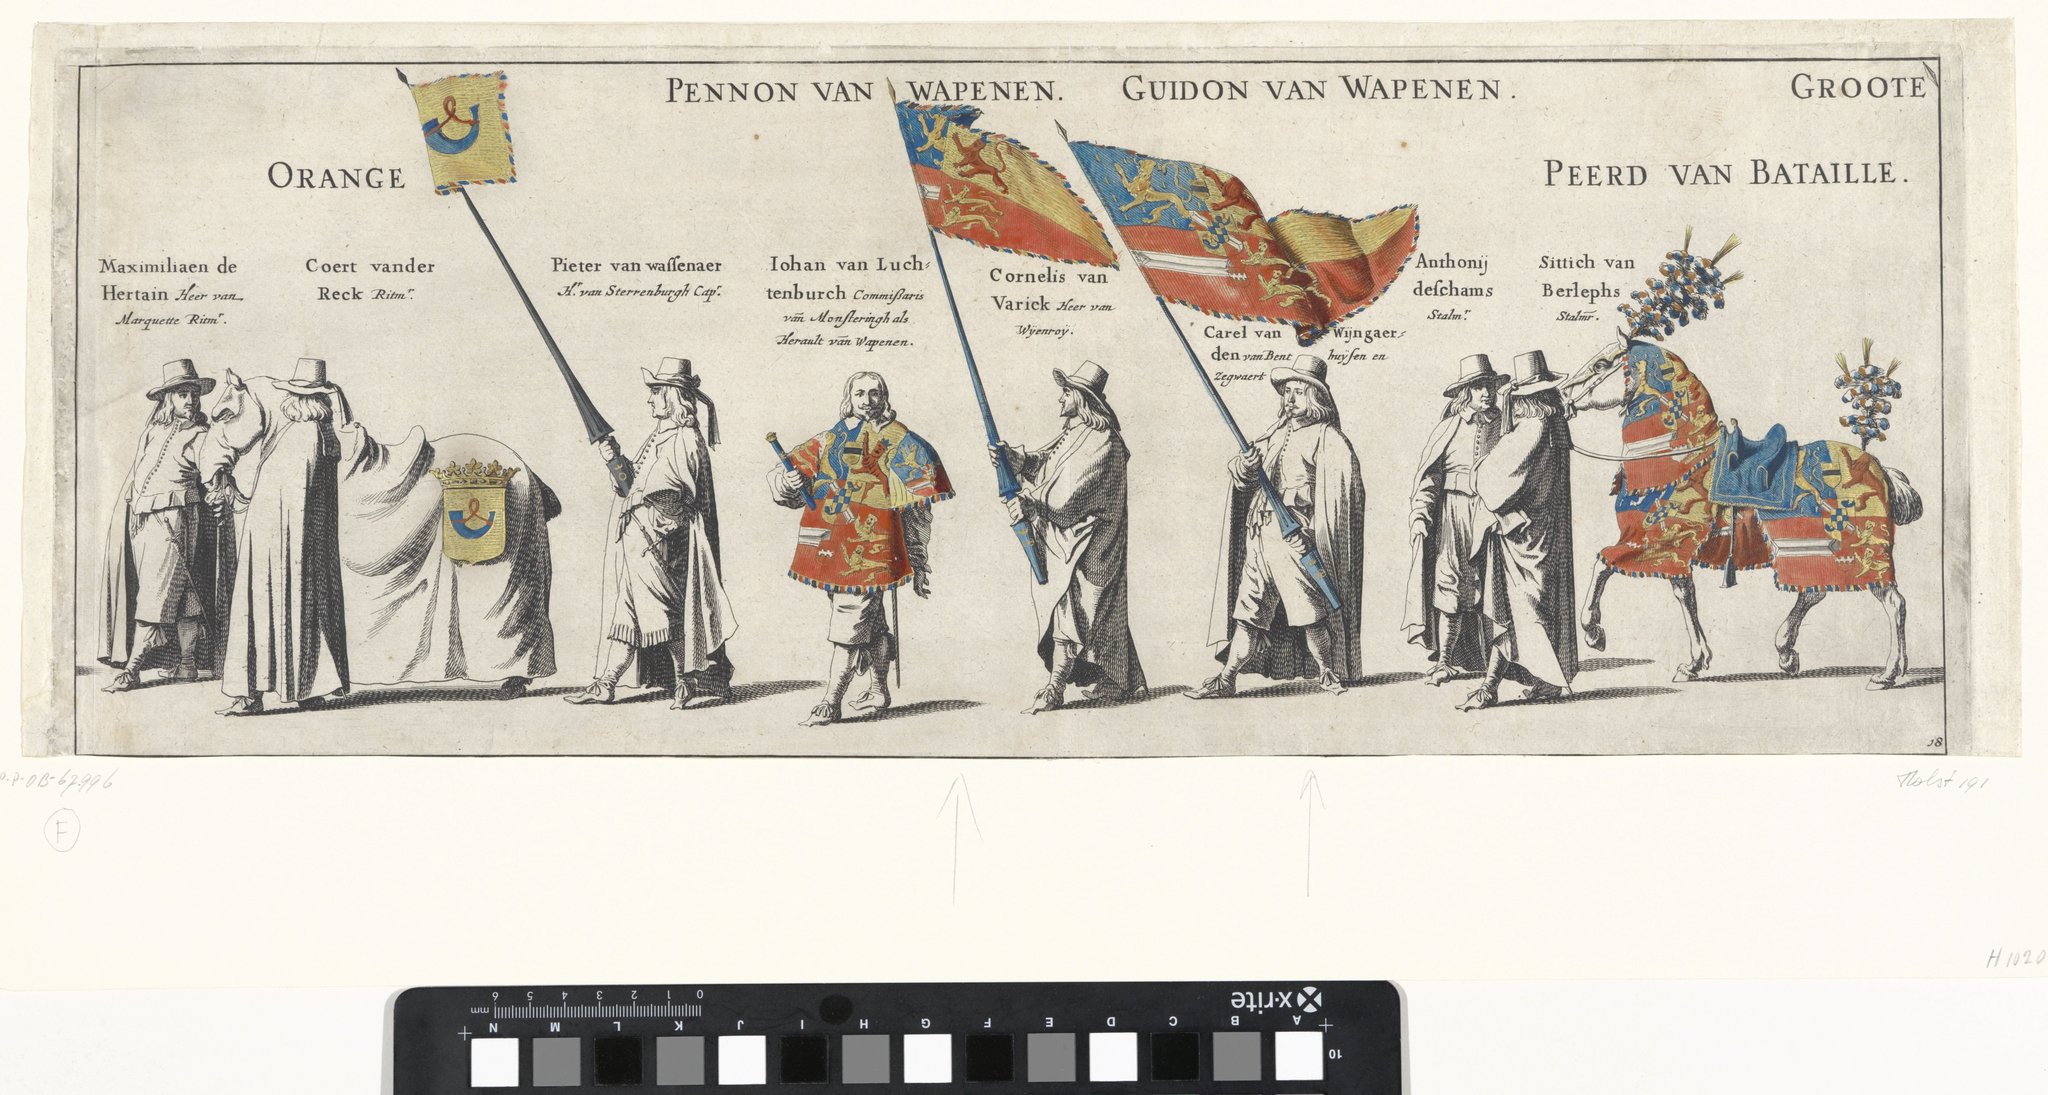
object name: print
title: Portret van Jean Perrault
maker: claude mellan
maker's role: draughtsman, print maker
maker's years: 1598-1688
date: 1652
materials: paper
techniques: engraving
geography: france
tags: historical persons, armorial bearing, heraldry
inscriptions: collector's mark: Lugt 240, title: ‘President Perot.’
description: Voorbereidende tekening in: Hermitage Sint-Petersburg, inv. nr. 4612.